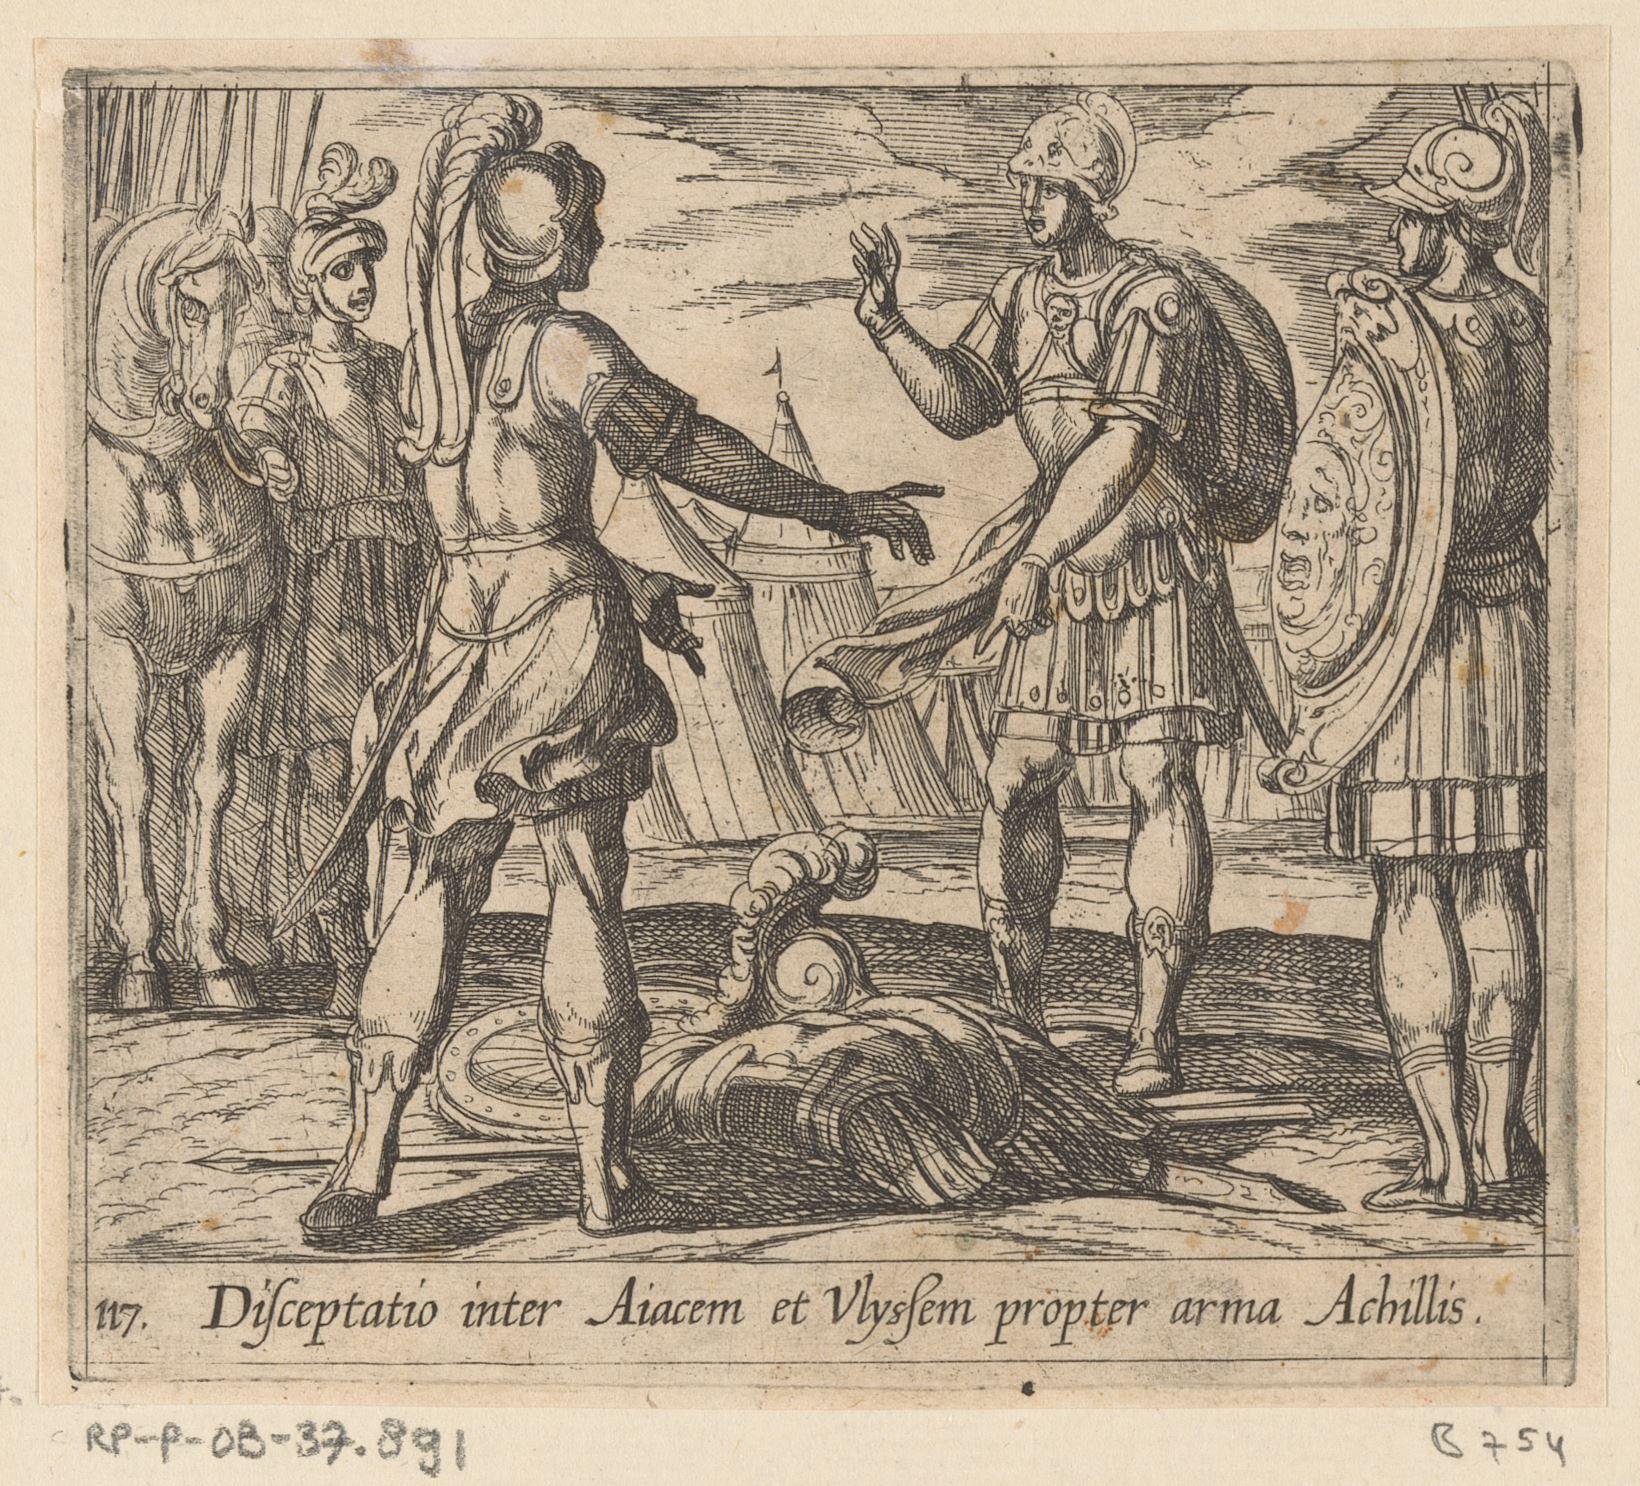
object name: print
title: Disceptatio inter Aiacem et Ulyssem propter arma Achilles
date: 1606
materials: paper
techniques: etching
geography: italy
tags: fight between ulysses and ajax the great for achilles' arms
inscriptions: collector's mark: Lugt 240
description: Deze prent maakt deel uit van een reeks van 150 prenten (+ titelprent) met voorstellingen van de Metamorfosen van Ovidius.